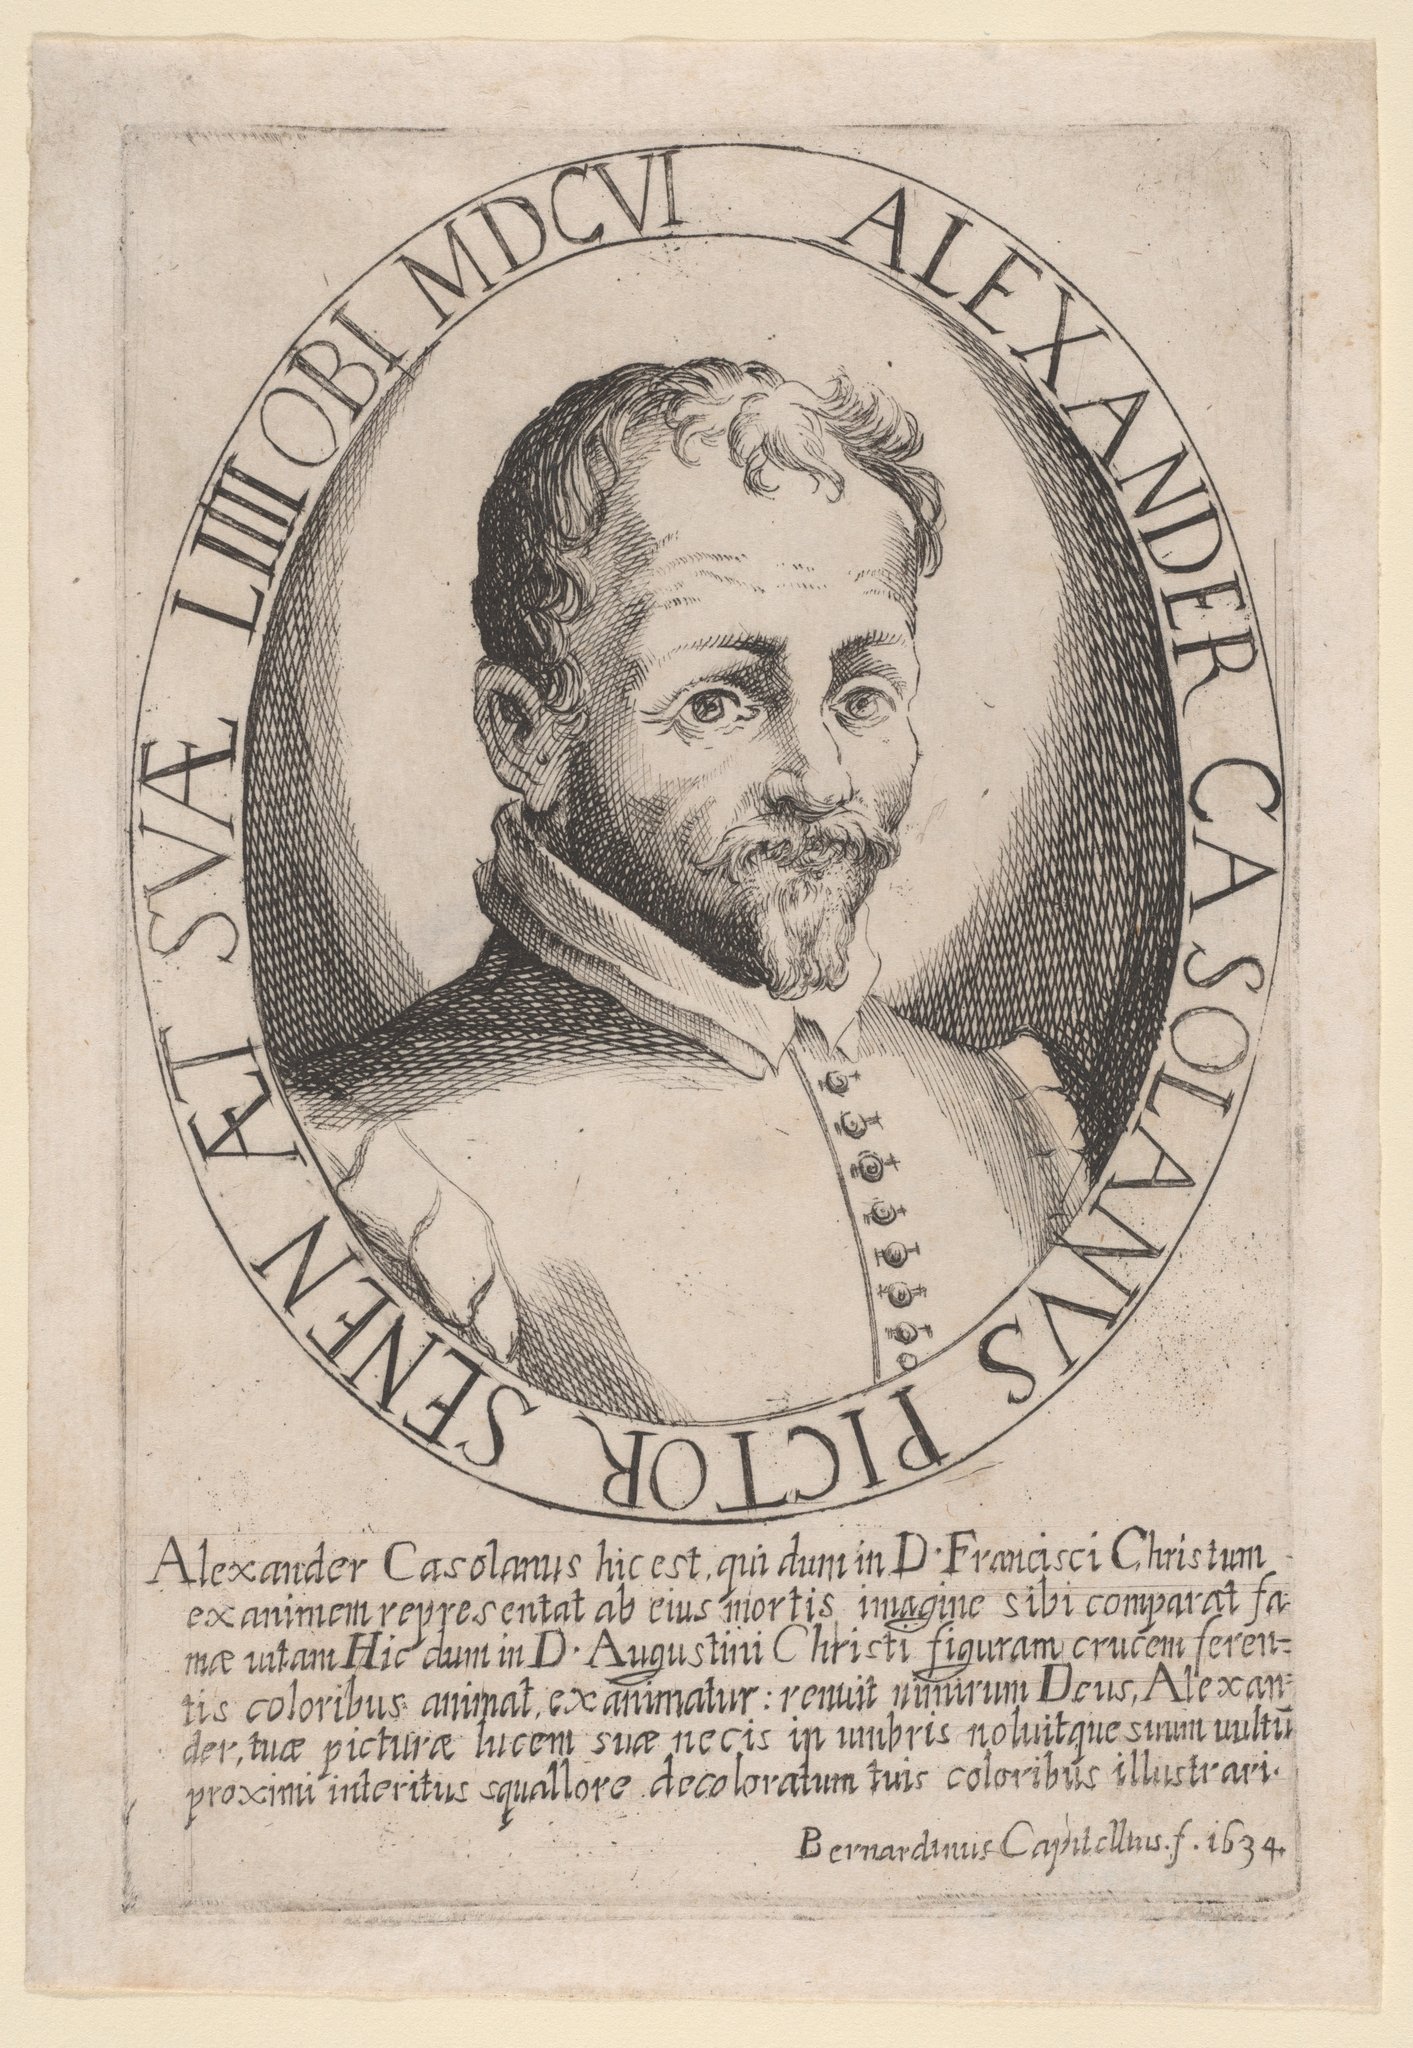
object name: print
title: Portrait of Alessandro Casolani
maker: bernardino capitelli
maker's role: artist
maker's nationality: italian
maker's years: 1590-1639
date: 1634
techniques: etching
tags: men,portraits